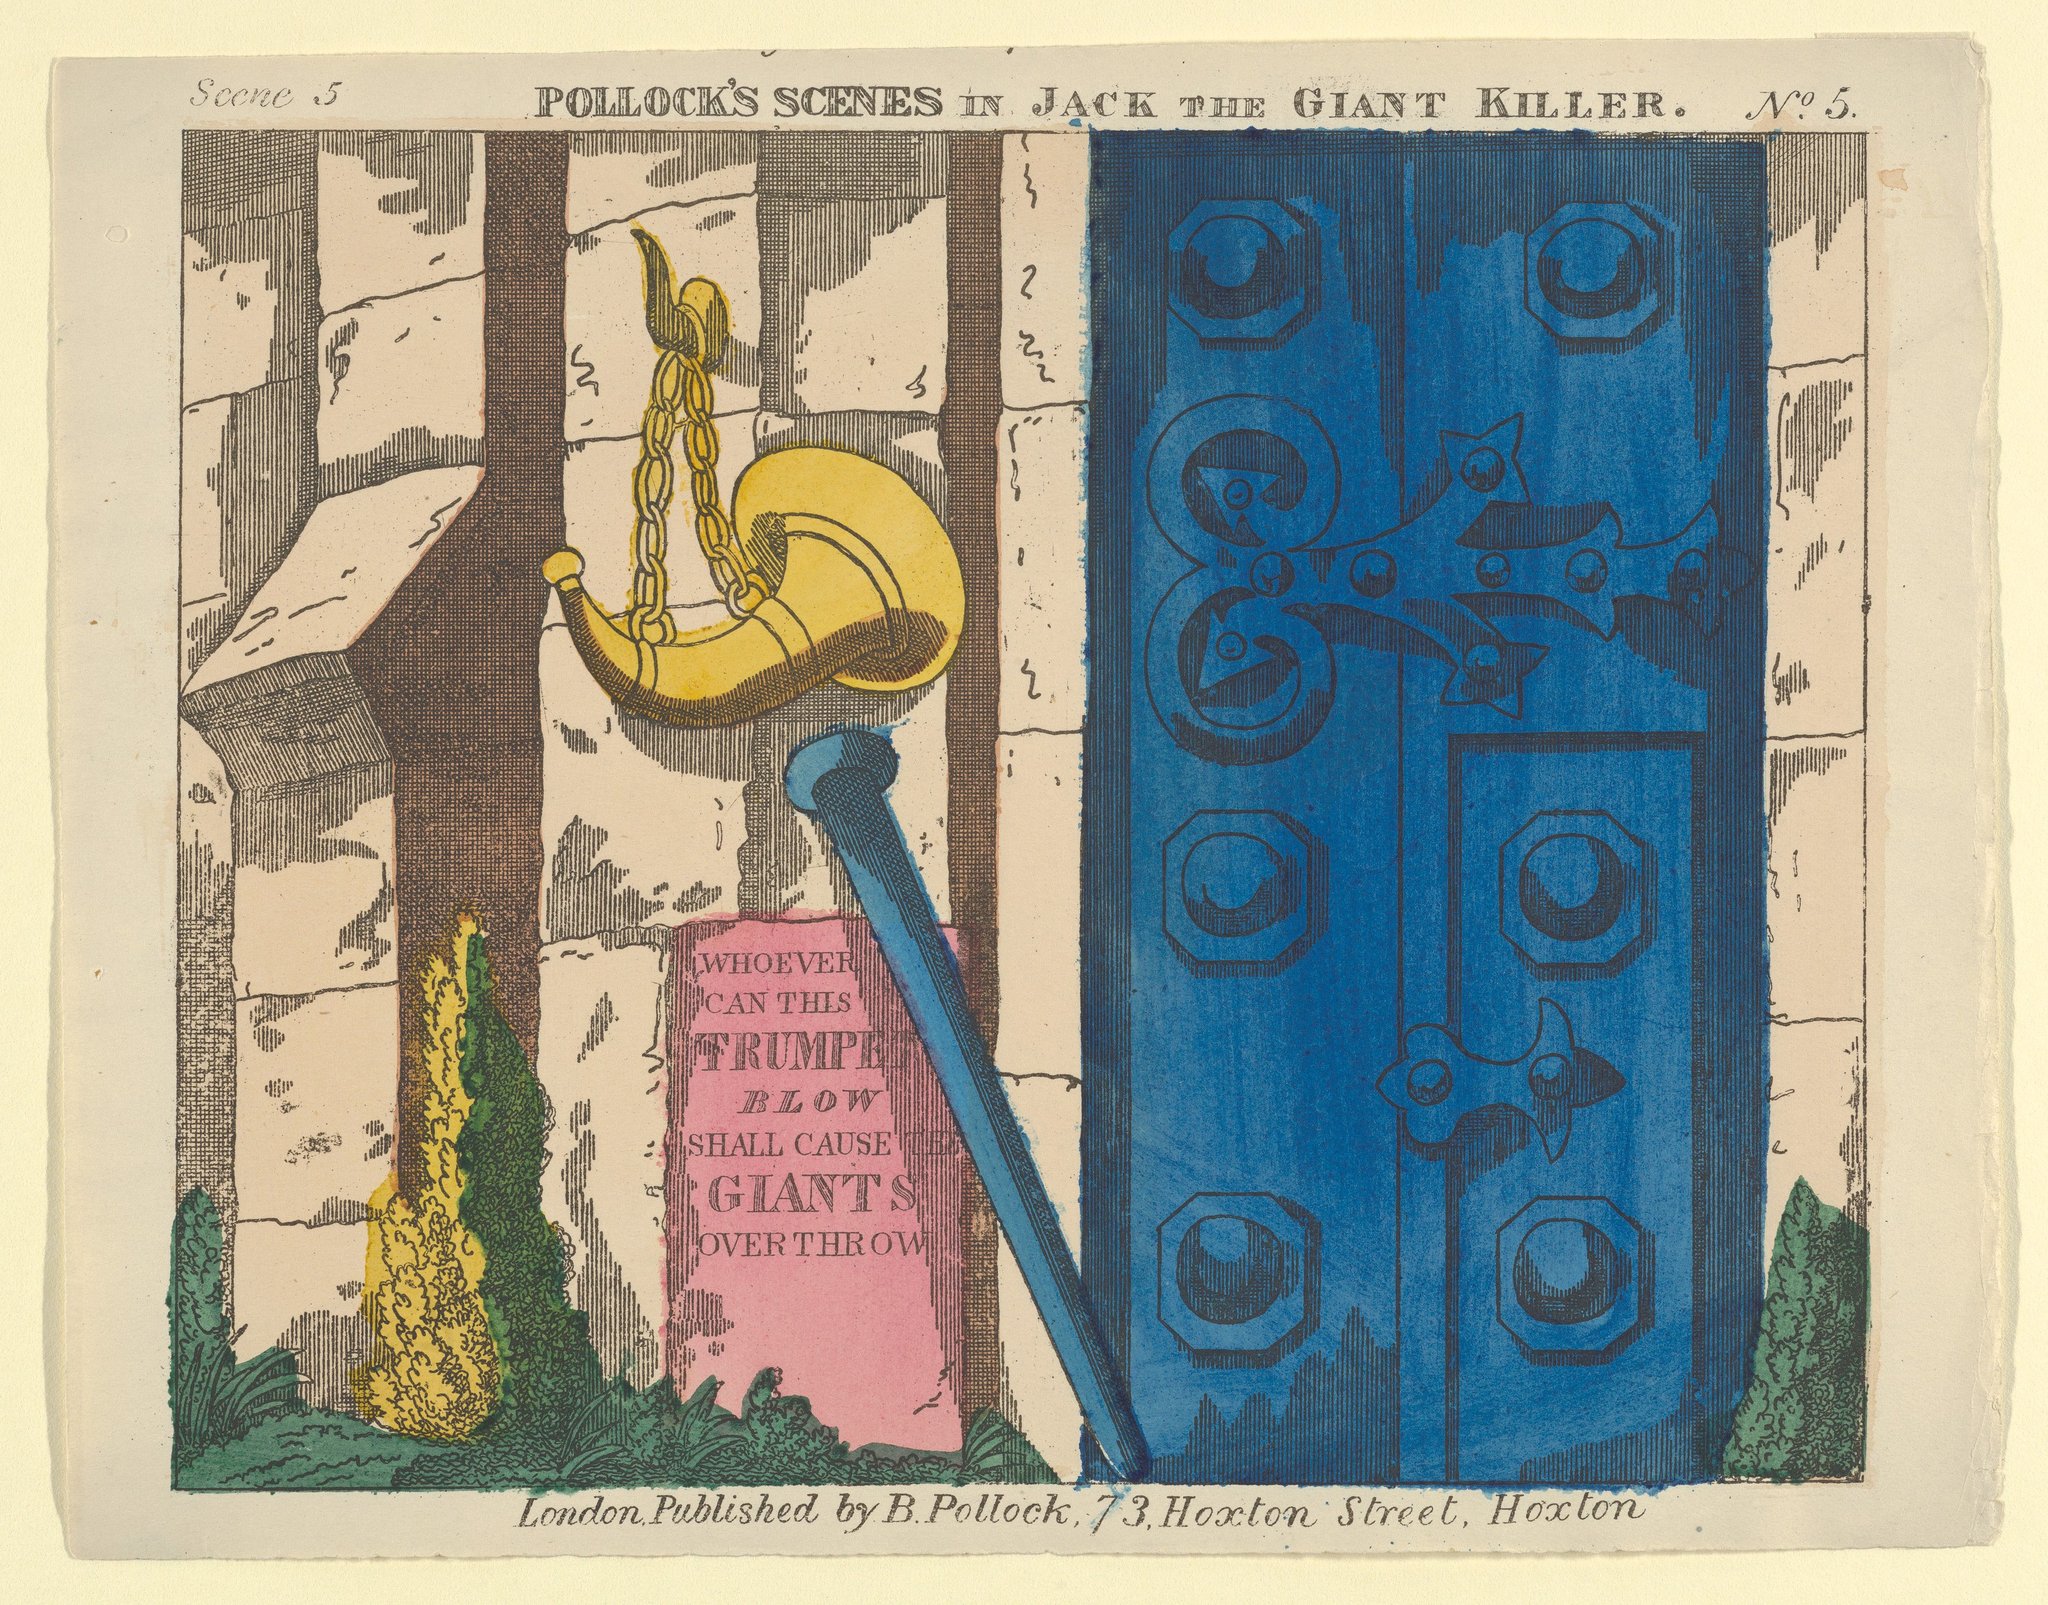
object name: print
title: Scene 5, from Jack and the Giant Killer, Scenes for a Toy Theater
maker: benjamin pollock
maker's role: publisher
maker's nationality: british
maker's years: 1857-1937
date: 1870-1890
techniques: lithograph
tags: musical instruments,doors